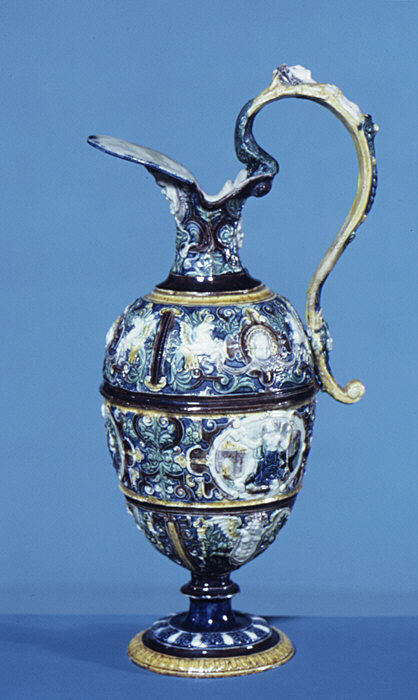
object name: ewer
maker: bernard palissy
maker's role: maker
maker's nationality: french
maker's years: 1510-1590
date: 1567-1633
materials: earthenware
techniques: glazing